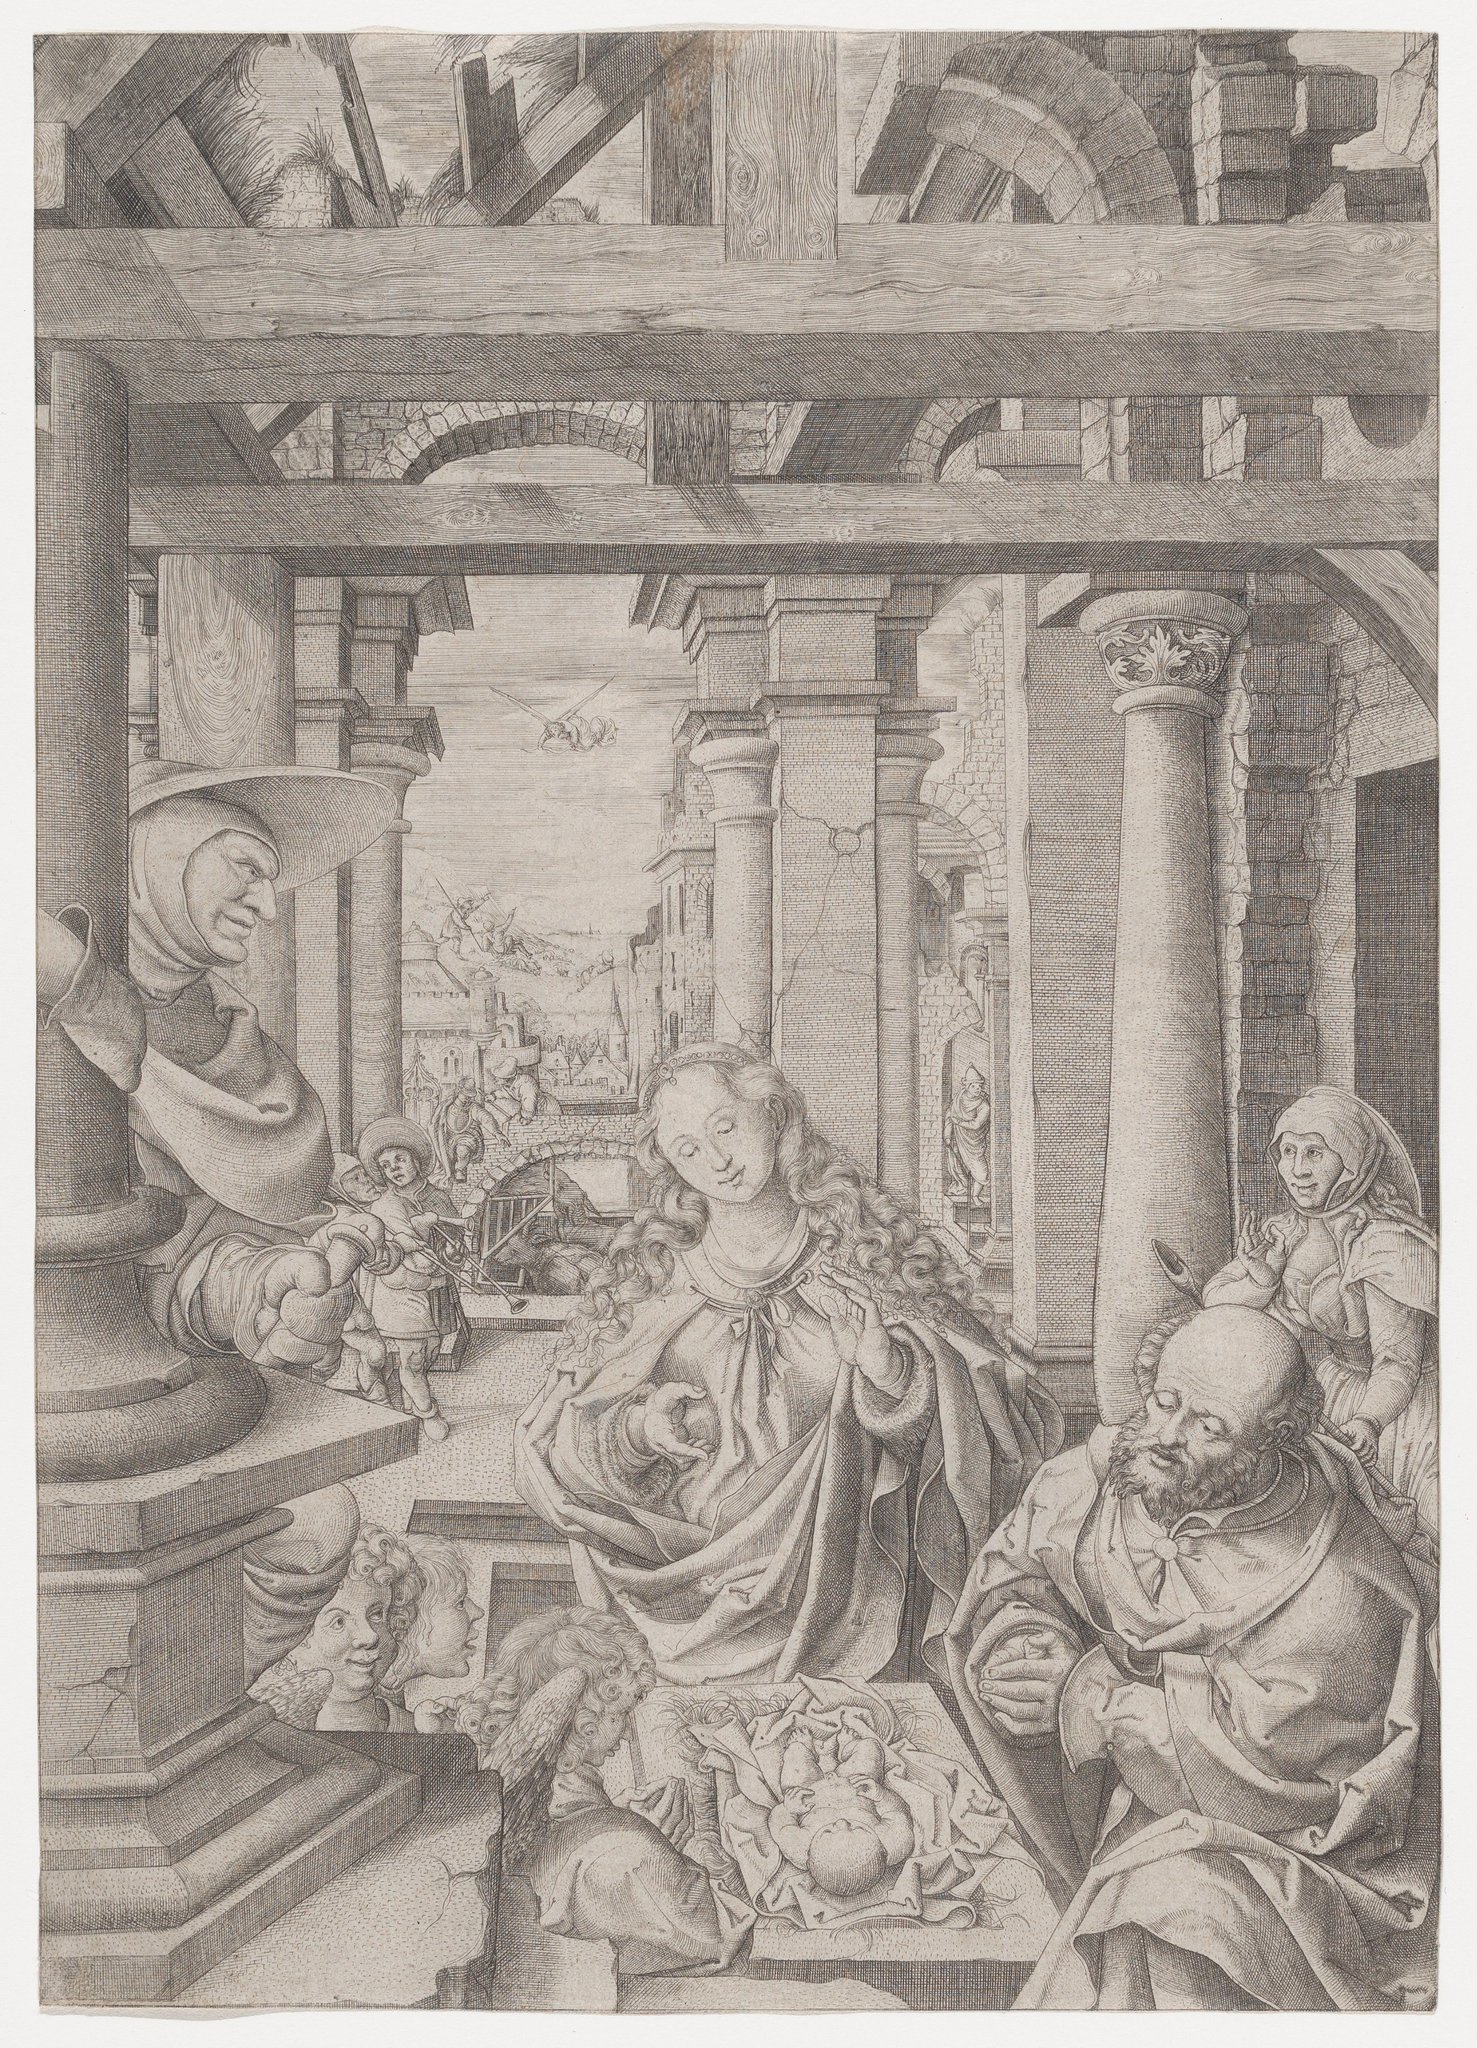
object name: print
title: The Adoration of the Shepherds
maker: frans crabbe van espleghem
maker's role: artist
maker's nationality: netherlandish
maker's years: 1480-1553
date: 1522-1525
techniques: engraving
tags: infants,men,women,jesus,adoration of the shepherds